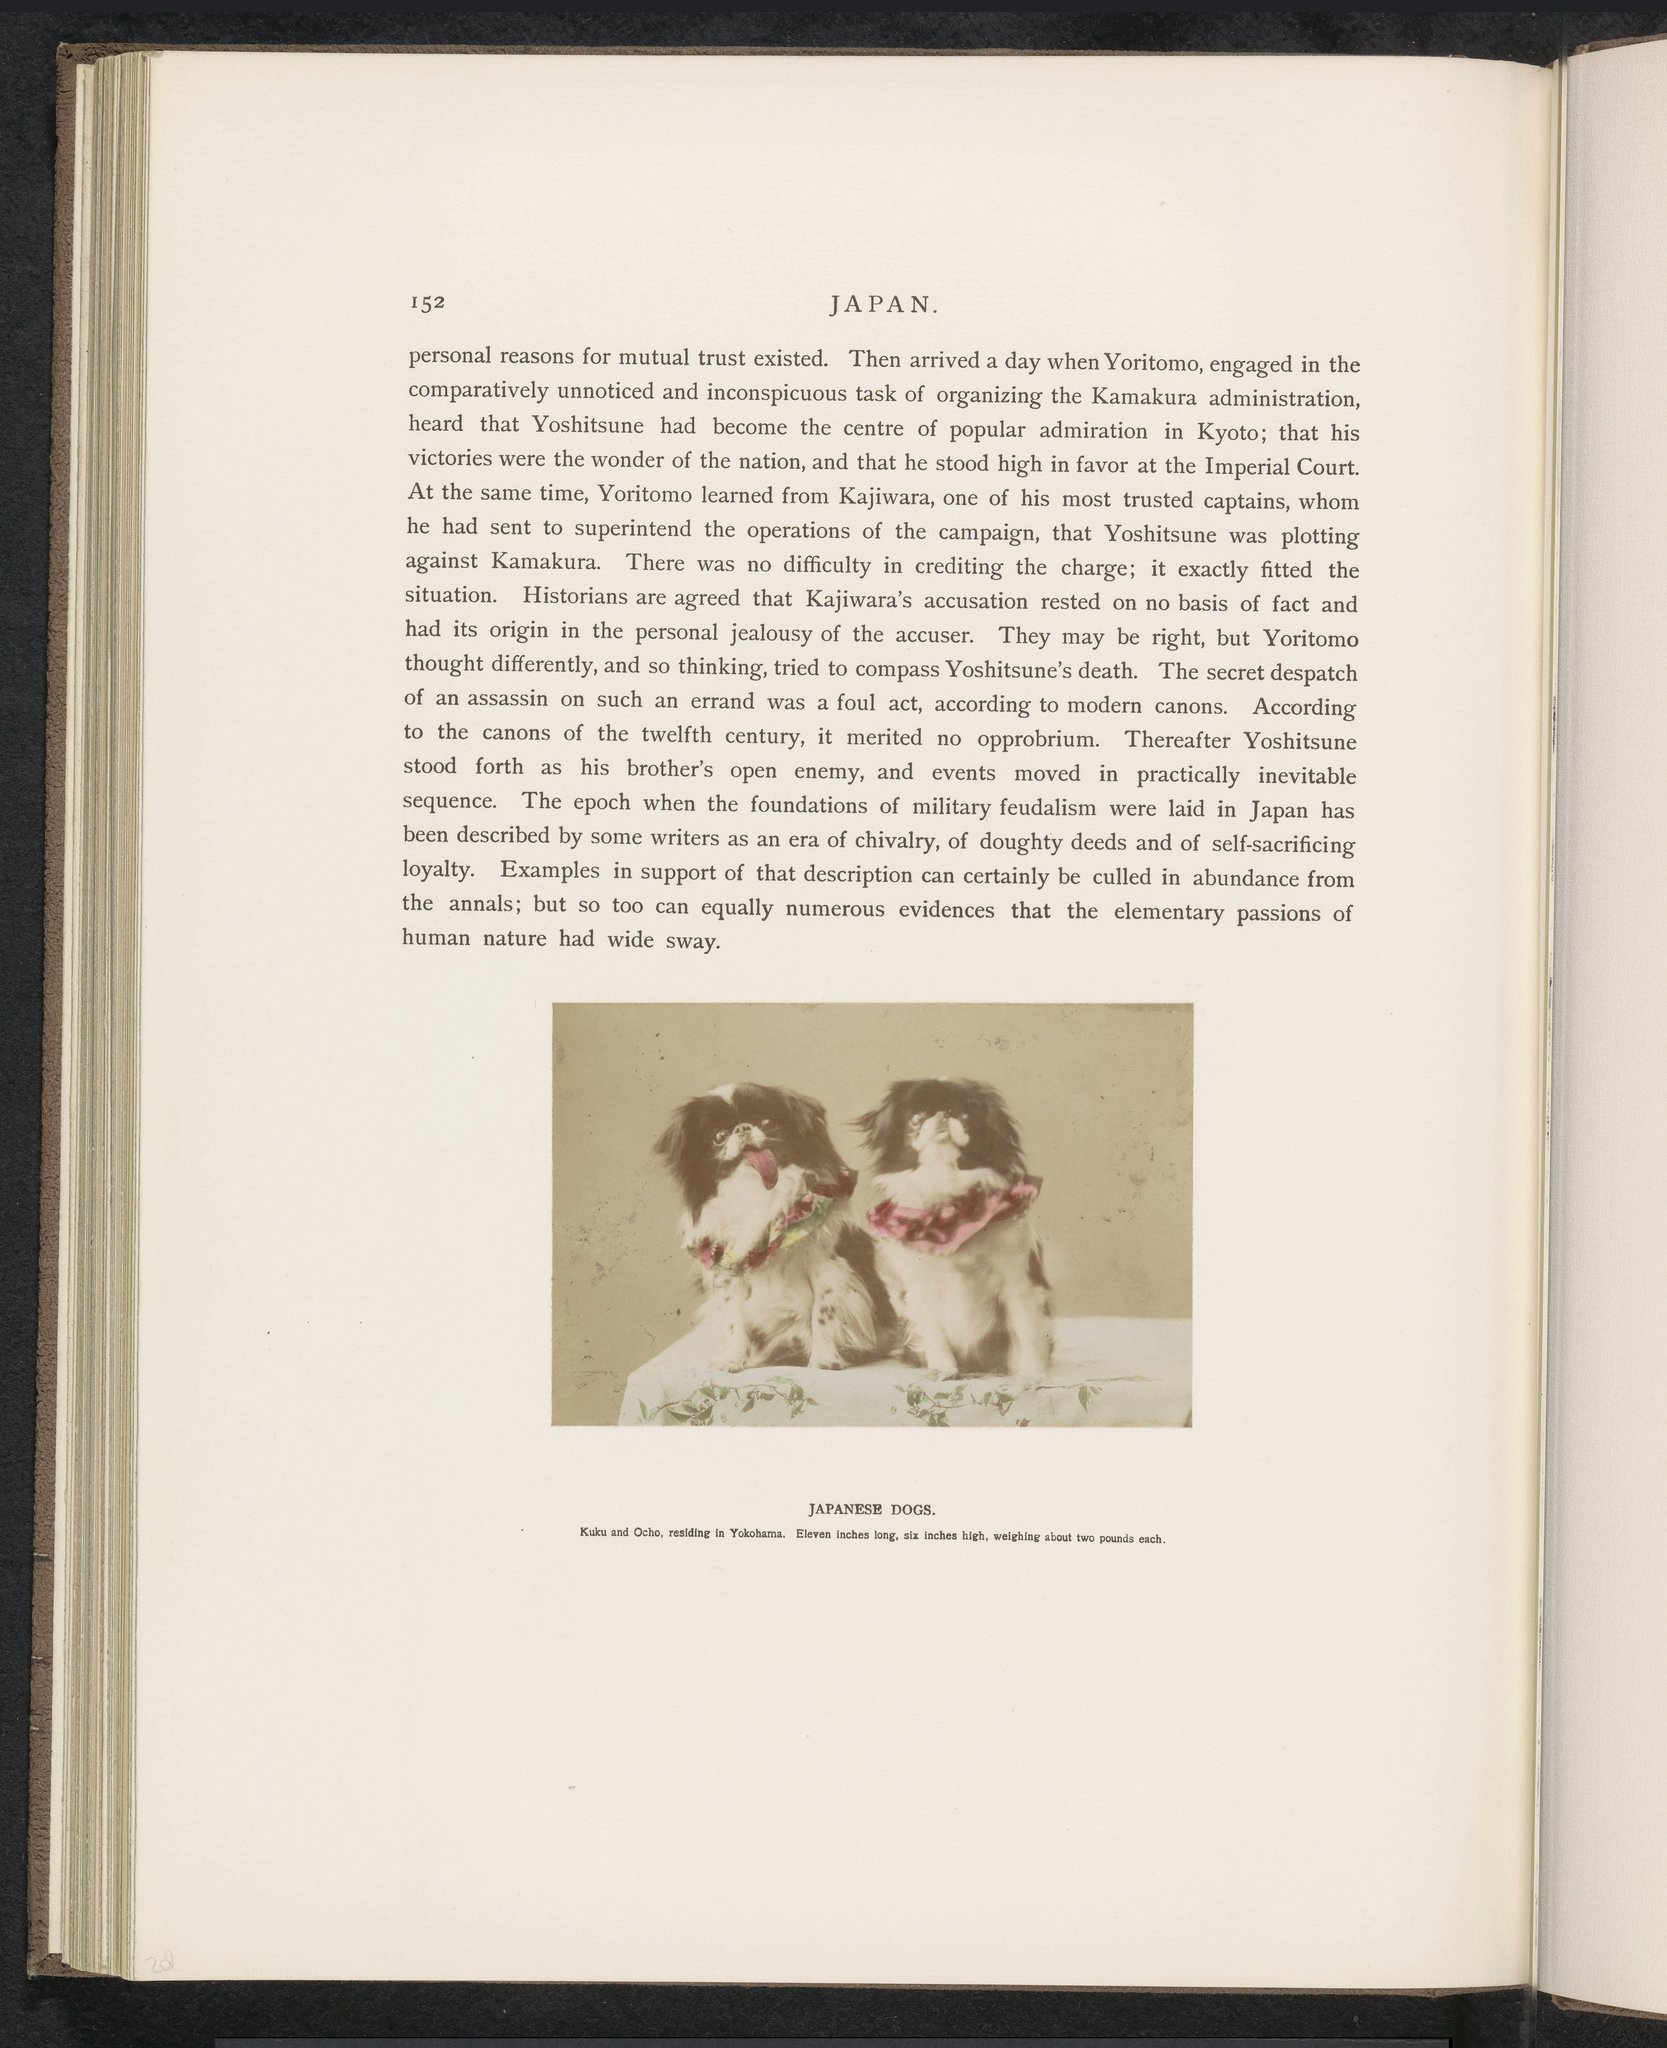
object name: photograph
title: Japanese dogs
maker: Anonymous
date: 1887-1897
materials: photographic support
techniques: albumen print, hand coloring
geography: japan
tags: dog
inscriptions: inscription: ‘Kuku and Ocho, residing in Yokohama. Eleven inches long, six inches high, weighing about two pounds each.’